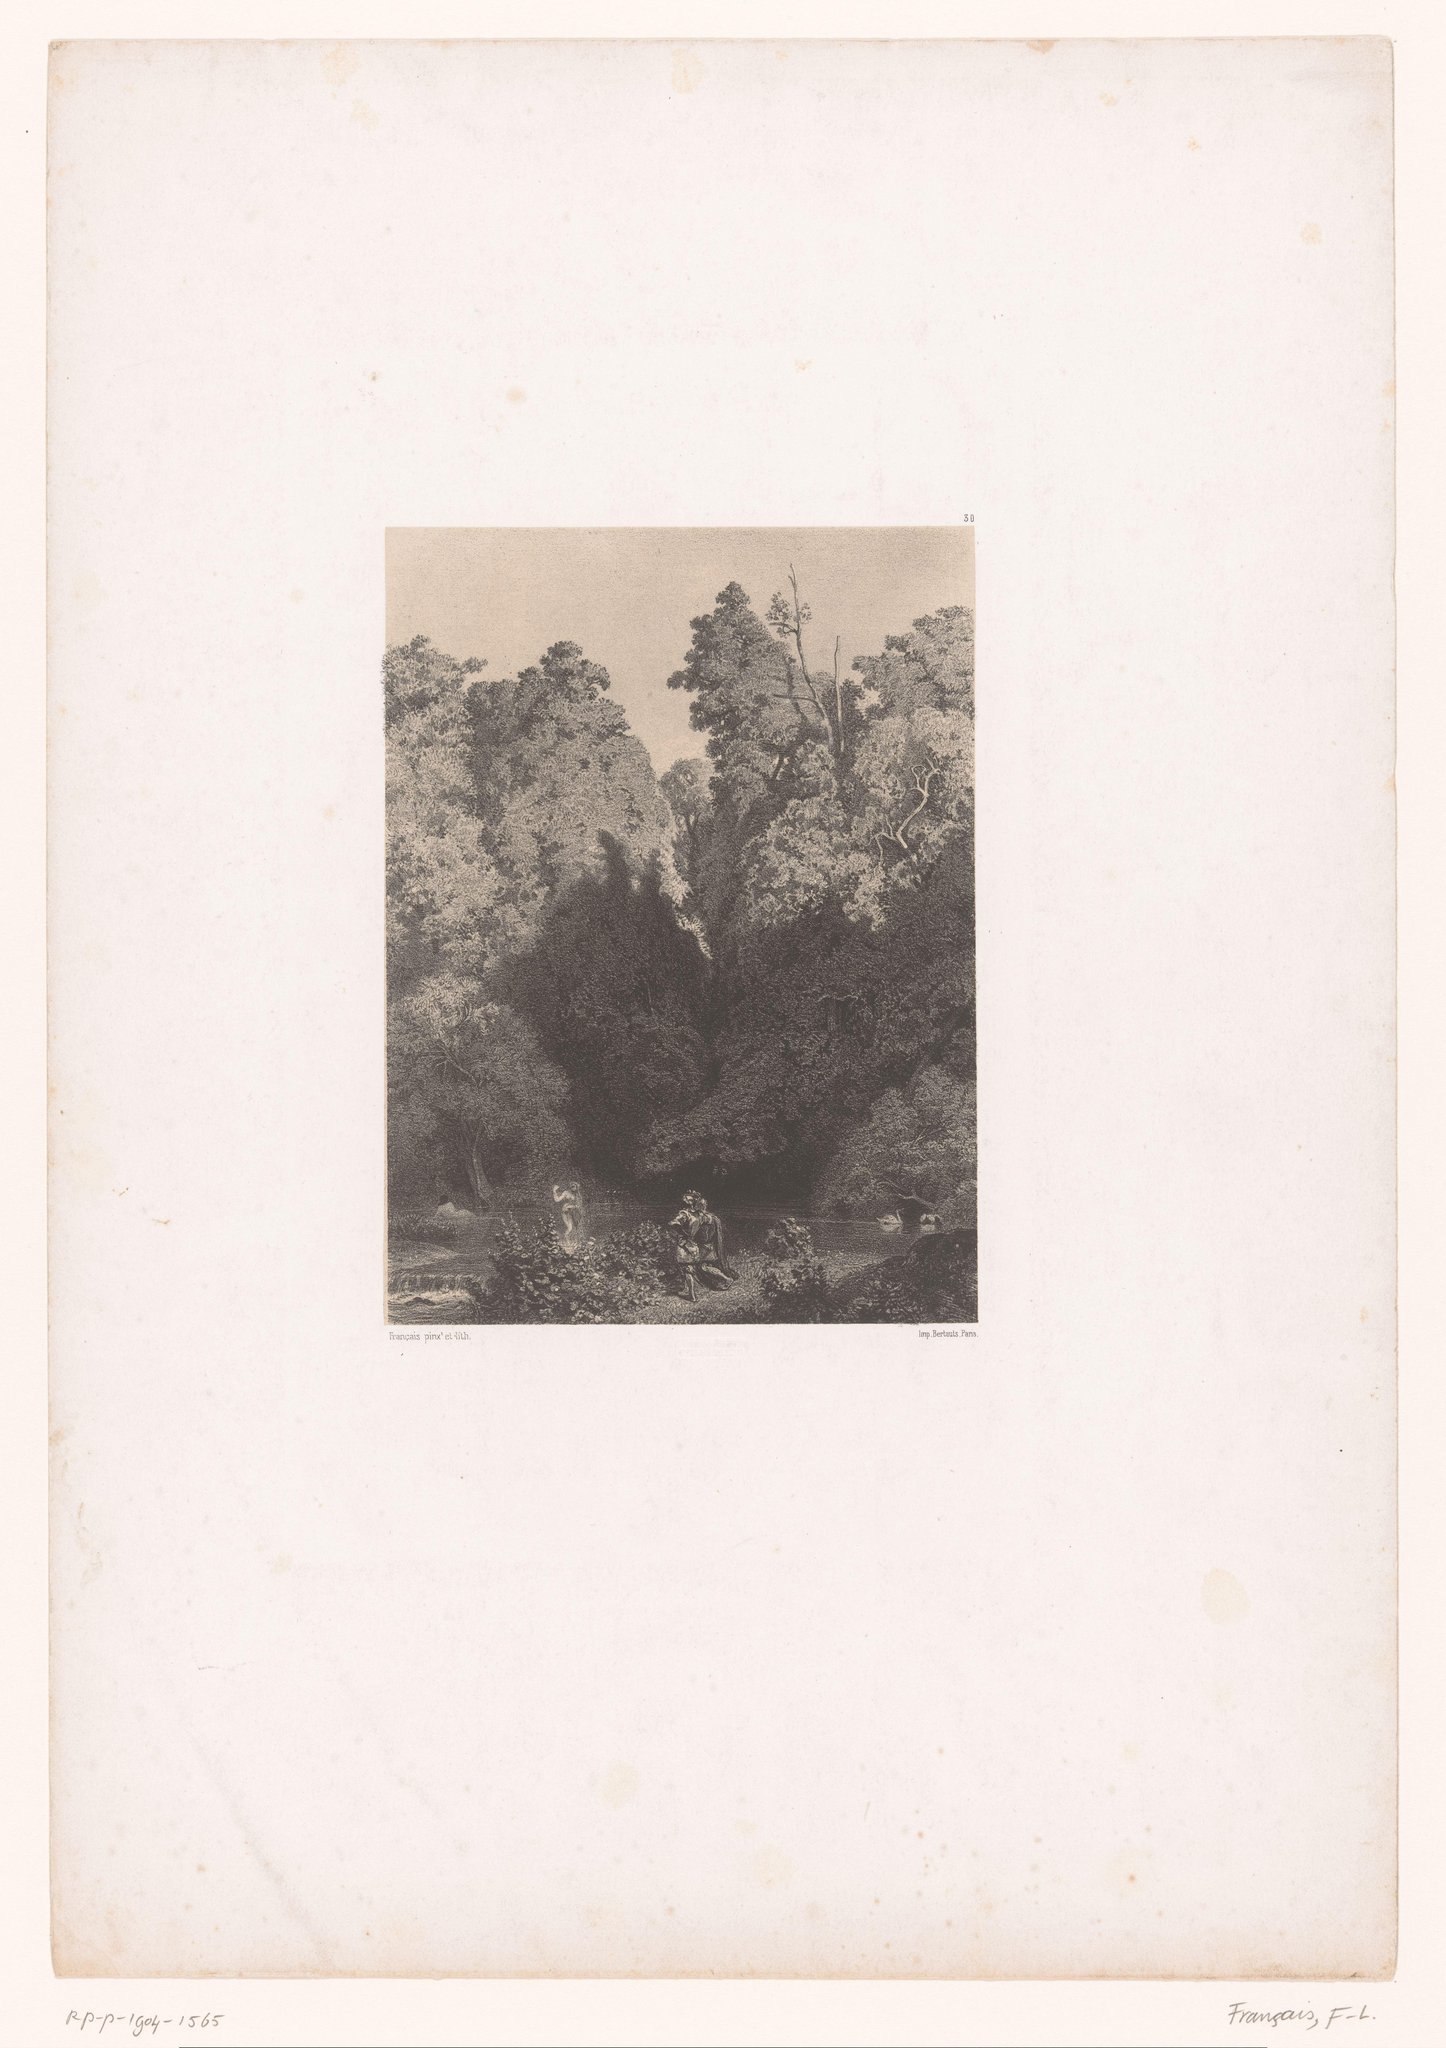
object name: print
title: Vijver in het bos met badende naakte vrouwen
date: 1852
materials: paper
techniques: tone lithography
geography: paris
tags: forest, wood, taking a bath - aa - in the open air, pond, pool (+ landscape with figures, staffage)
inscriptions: check stamp: Lugt 4776, collector's mark: Lugt 2228a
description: Prent gebruikt voor: Les Peintres Vivants, 1852.